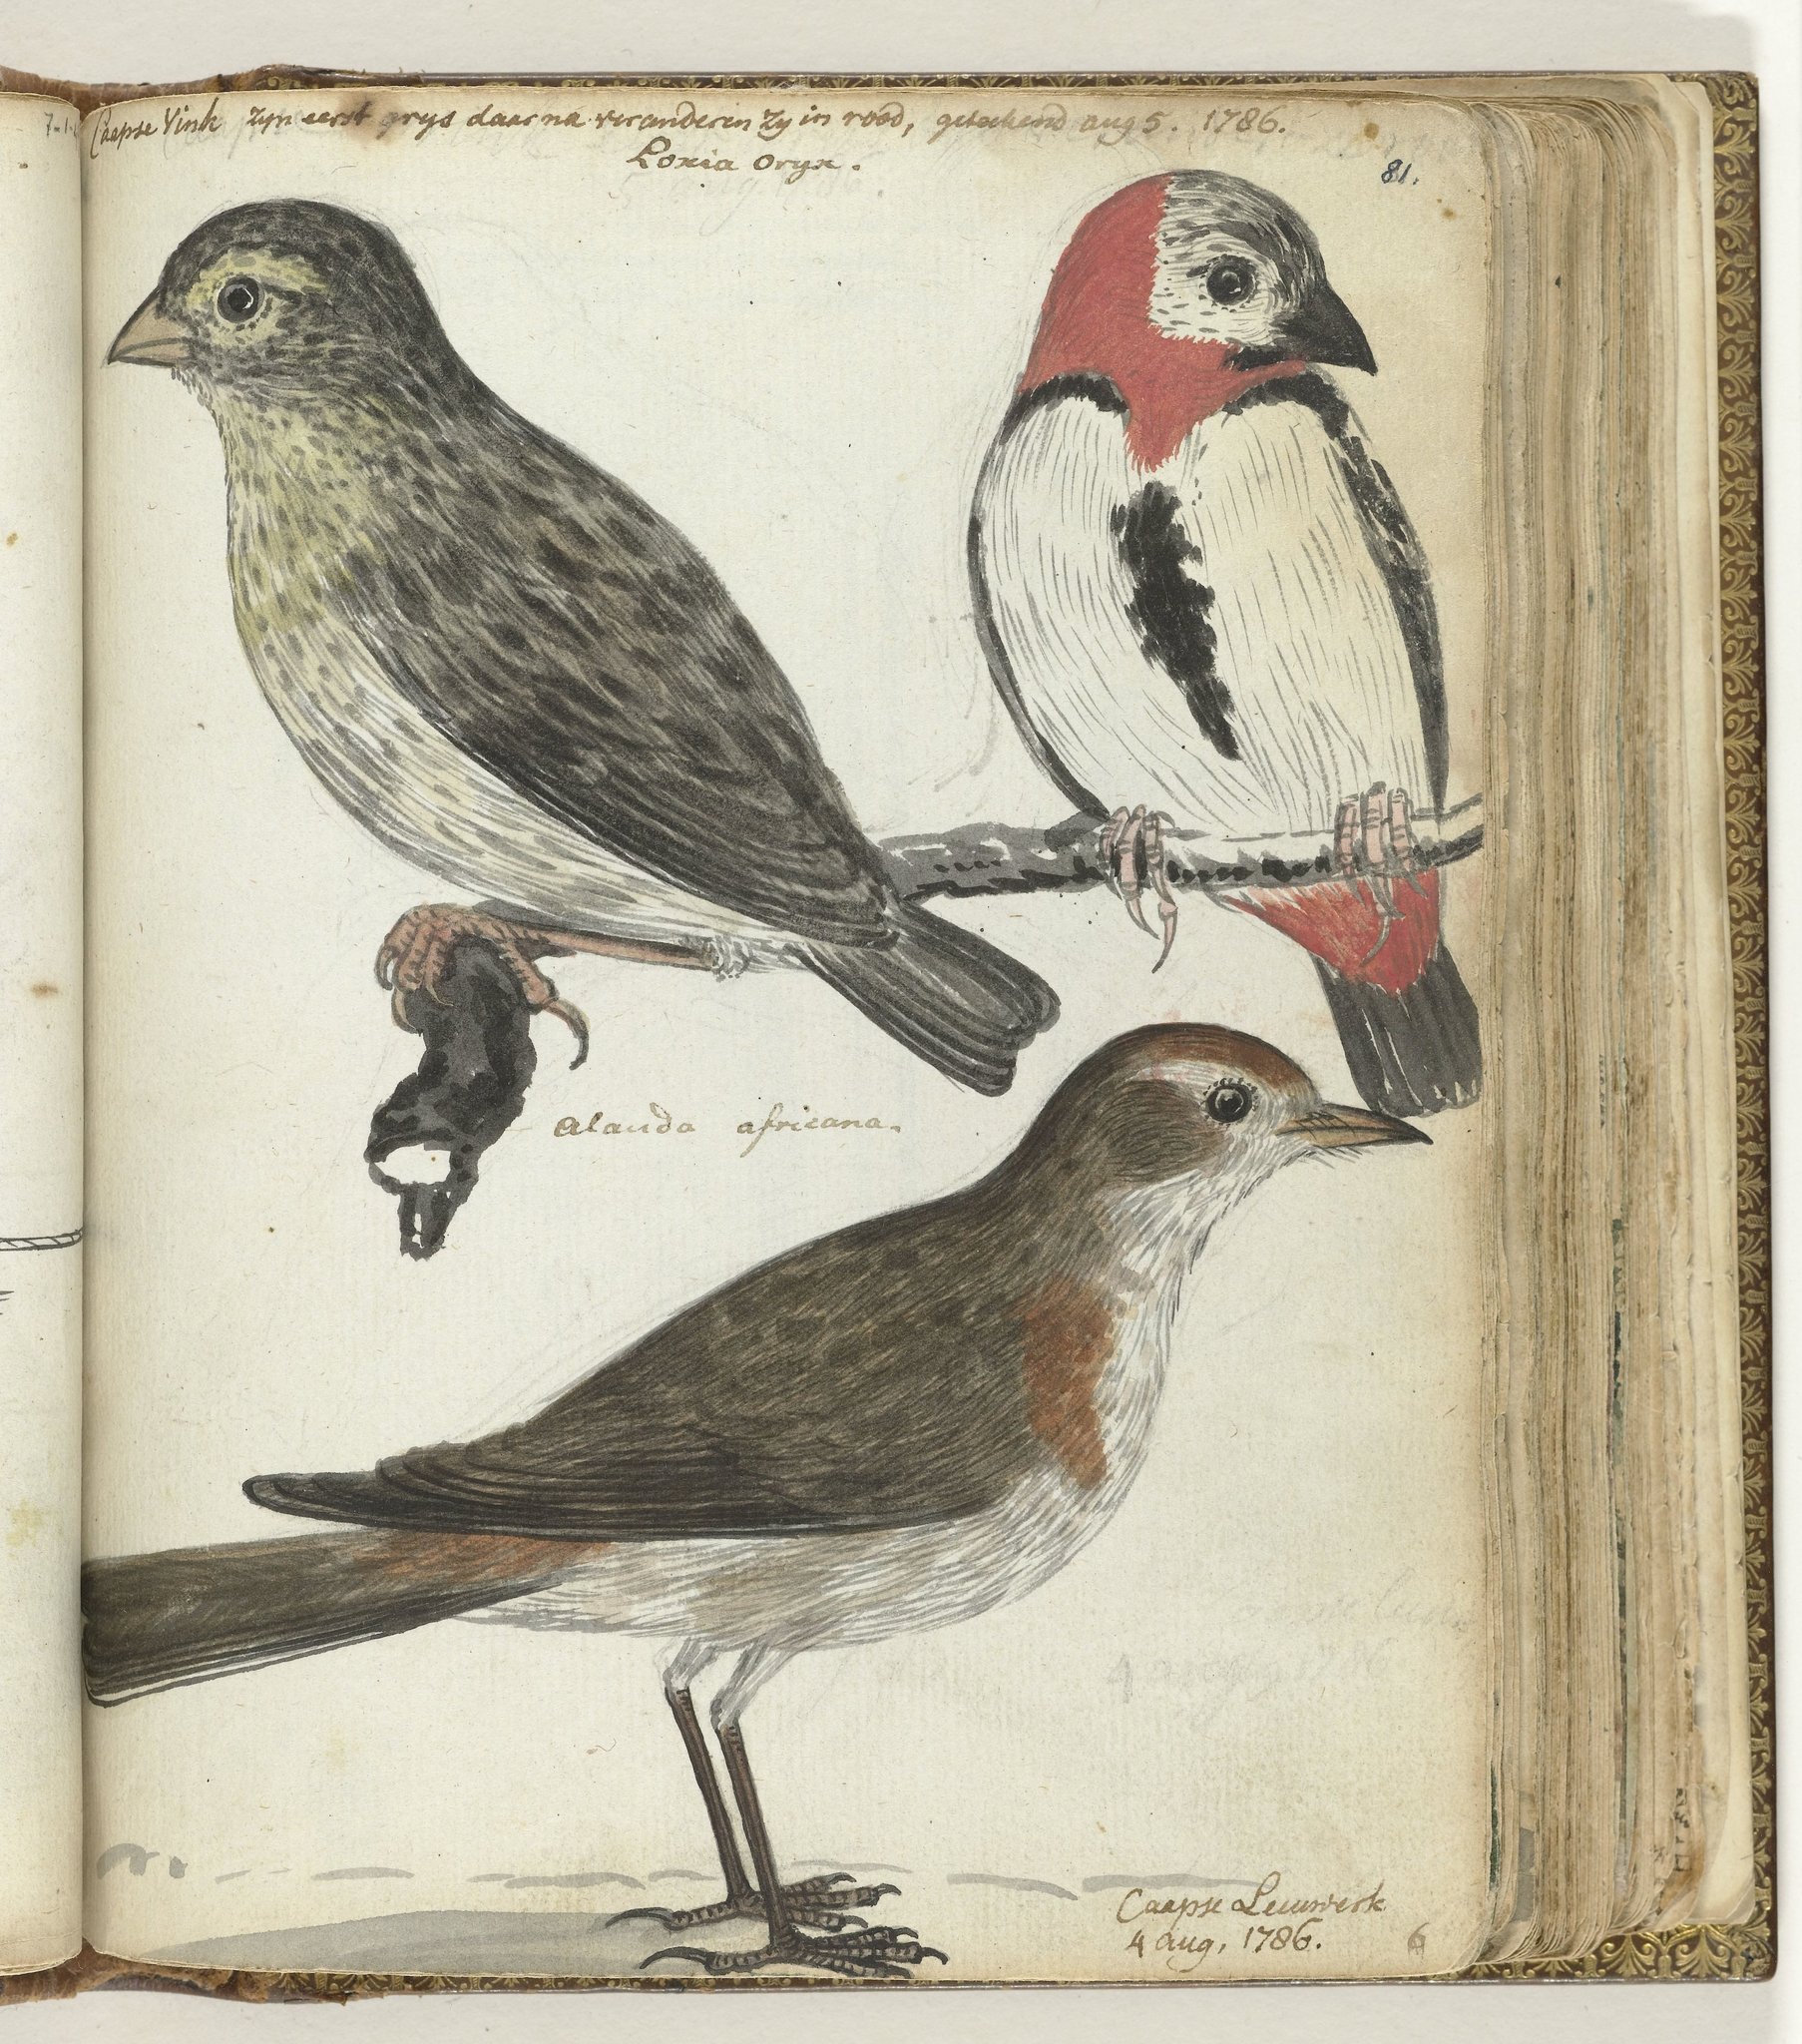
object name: drawing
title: Kaapse vogels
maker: jan brandes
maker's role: draughtsman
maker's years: 1743-1808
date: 1786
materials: paper, pencil, watercolor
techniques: brush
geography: cape town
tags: birds, cape of good hope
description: Kleurtekening van Kaapse vinken en een Kaapse leeuwerik. Met opschrift. Onderdeel uit het schetsboek van Jan Brandes, dl. 1 (1808), p. 81.